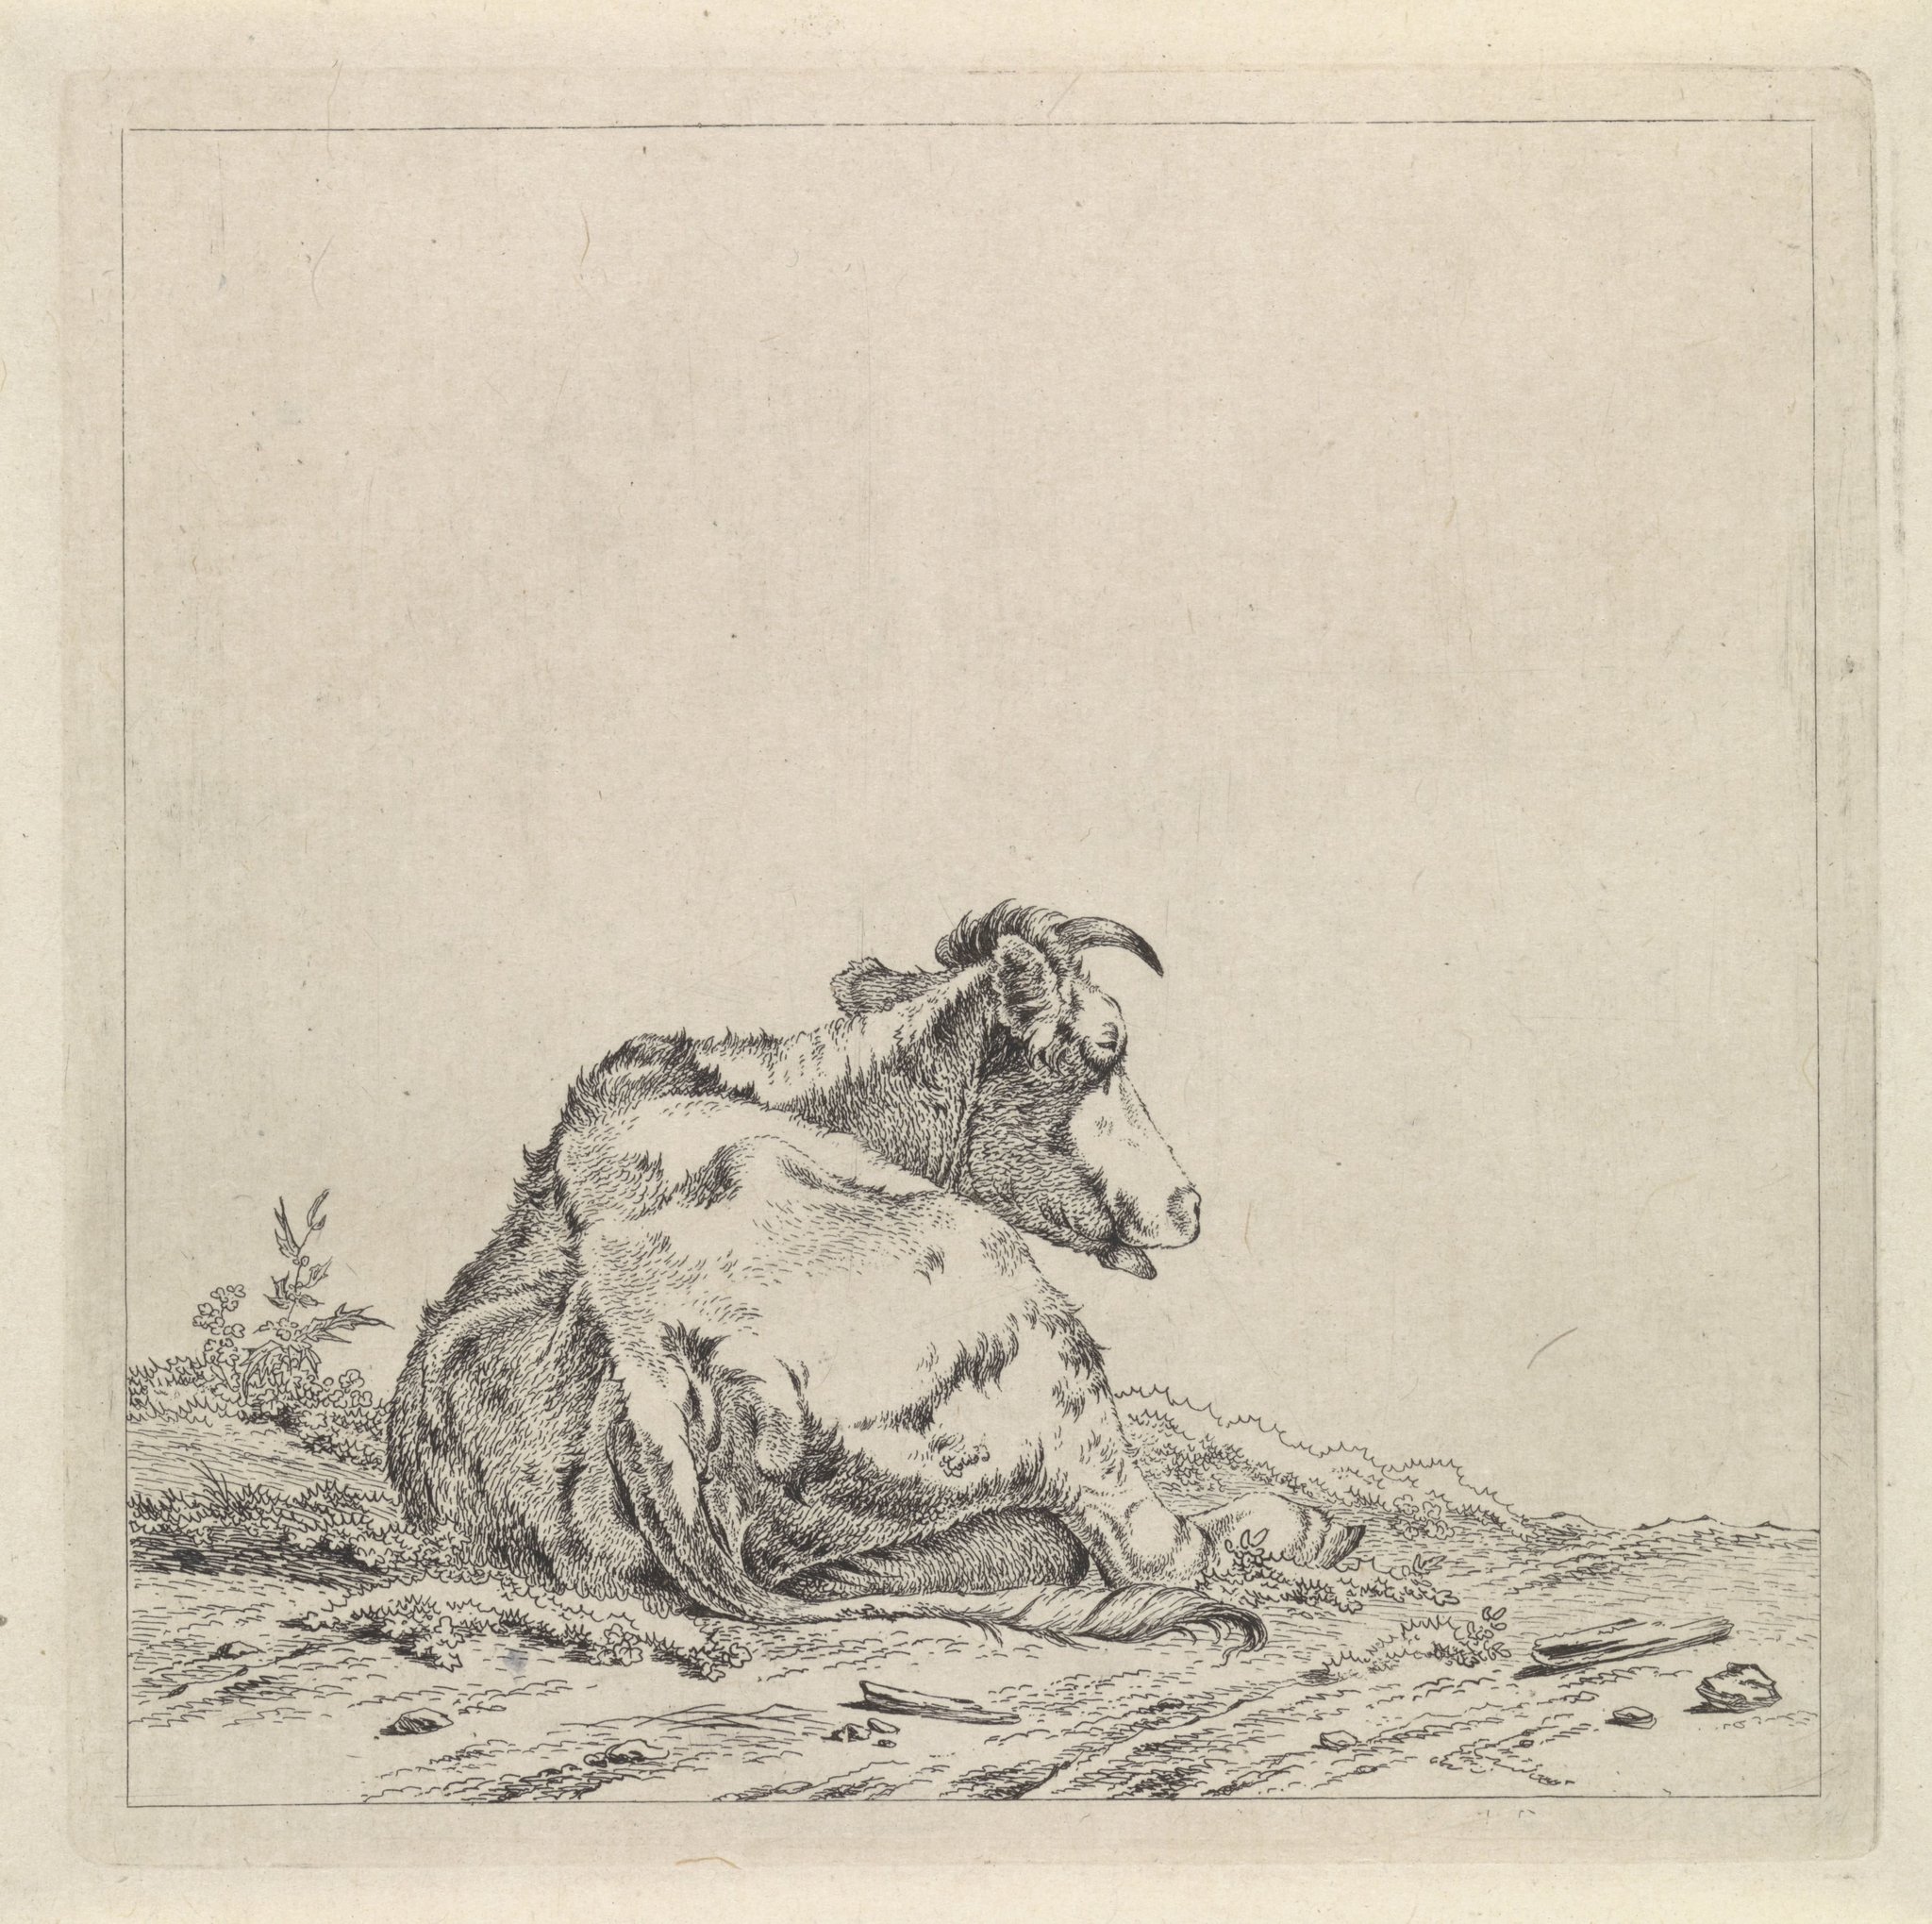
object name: print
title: Landschap met liggende koe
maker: pieter janson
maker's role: draughtsman, print maker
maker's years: 1765-1851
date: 1780-1851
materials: paper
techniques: etching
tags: cow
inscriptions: collector's mark: Lugt 2228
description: Landschap met liggende koe naar rechts, van achter gezien. Vóór de lucht en de achtergrond.